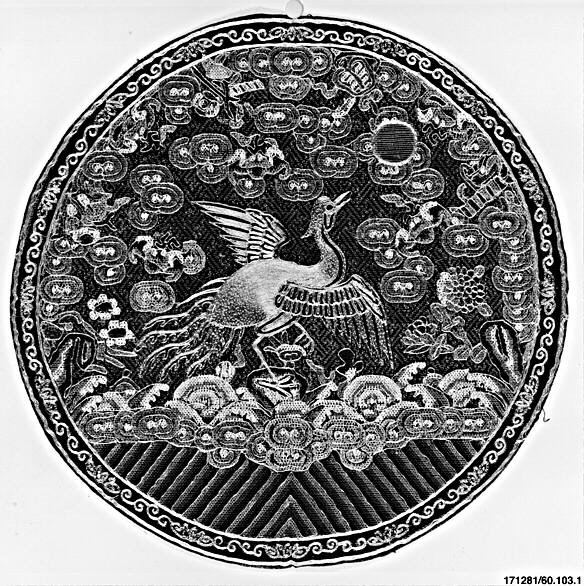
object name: rank badge or medallion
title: Rank Badge or Medallion with Silver Pheasant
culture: chinese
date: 1801-1900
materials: metal thread, silk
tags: pheasants